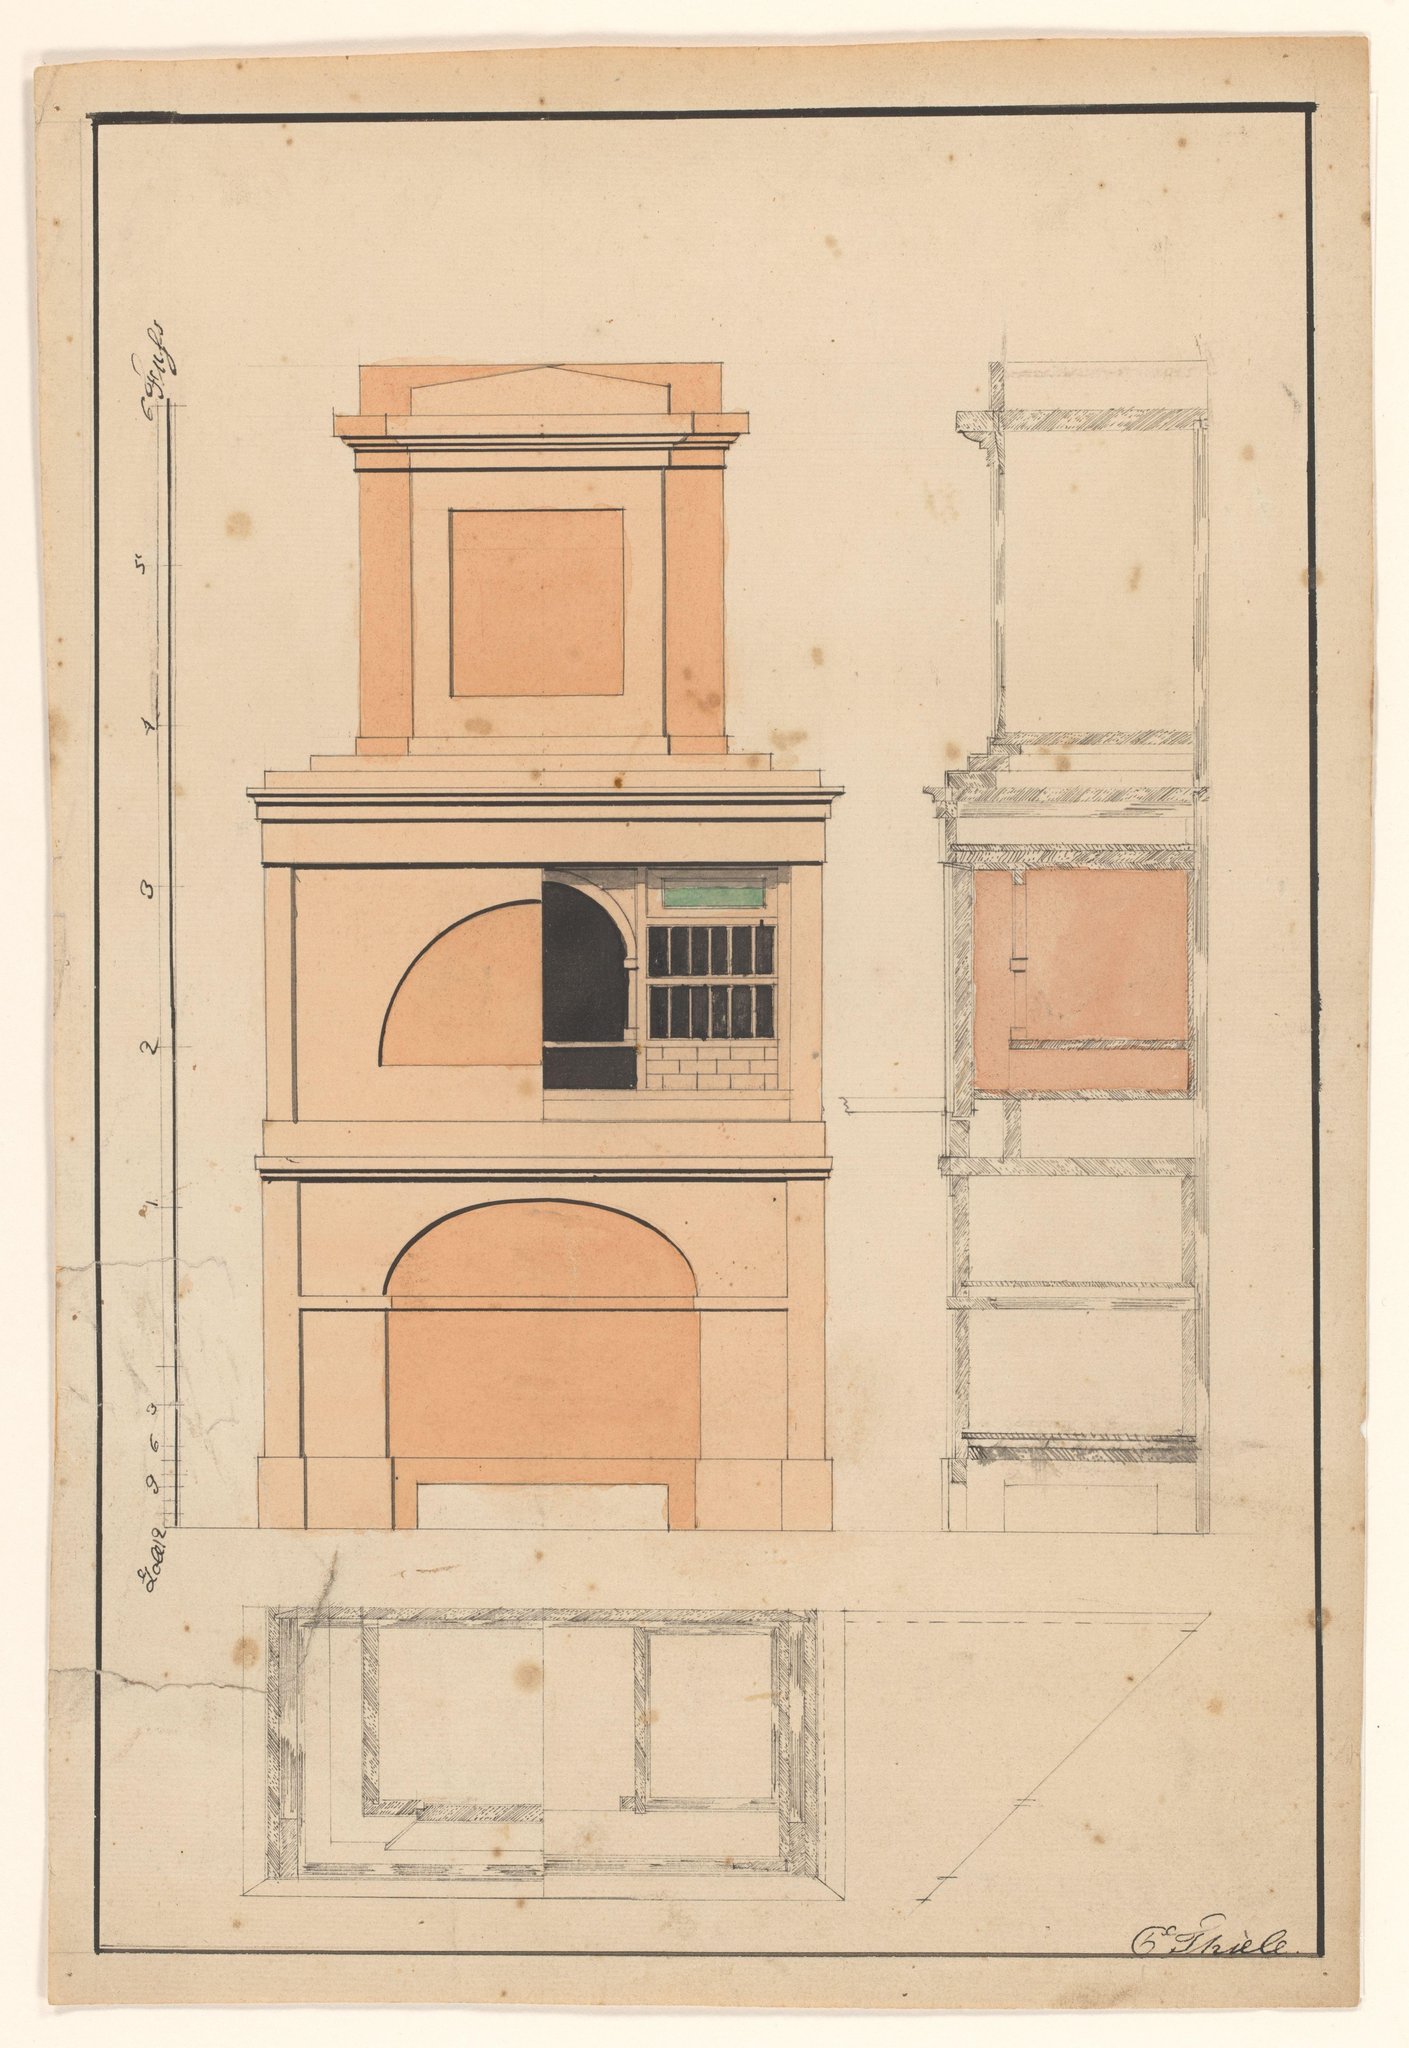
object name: design drawing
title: Ontwerp voor een secretaire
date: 1820-1830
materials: ink, paper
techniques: brush, pen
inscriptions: inscription: ‘Zoll 12 9 6 3 1 2 3 4 5 6 Fuss’, signature: ‘Cl Thiele’, watermark: ‘VDL’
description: Opstand, voor- en zijaanzicht, met daaronder een in tweeën gedeelde plattegrond, links een maatverdeling.